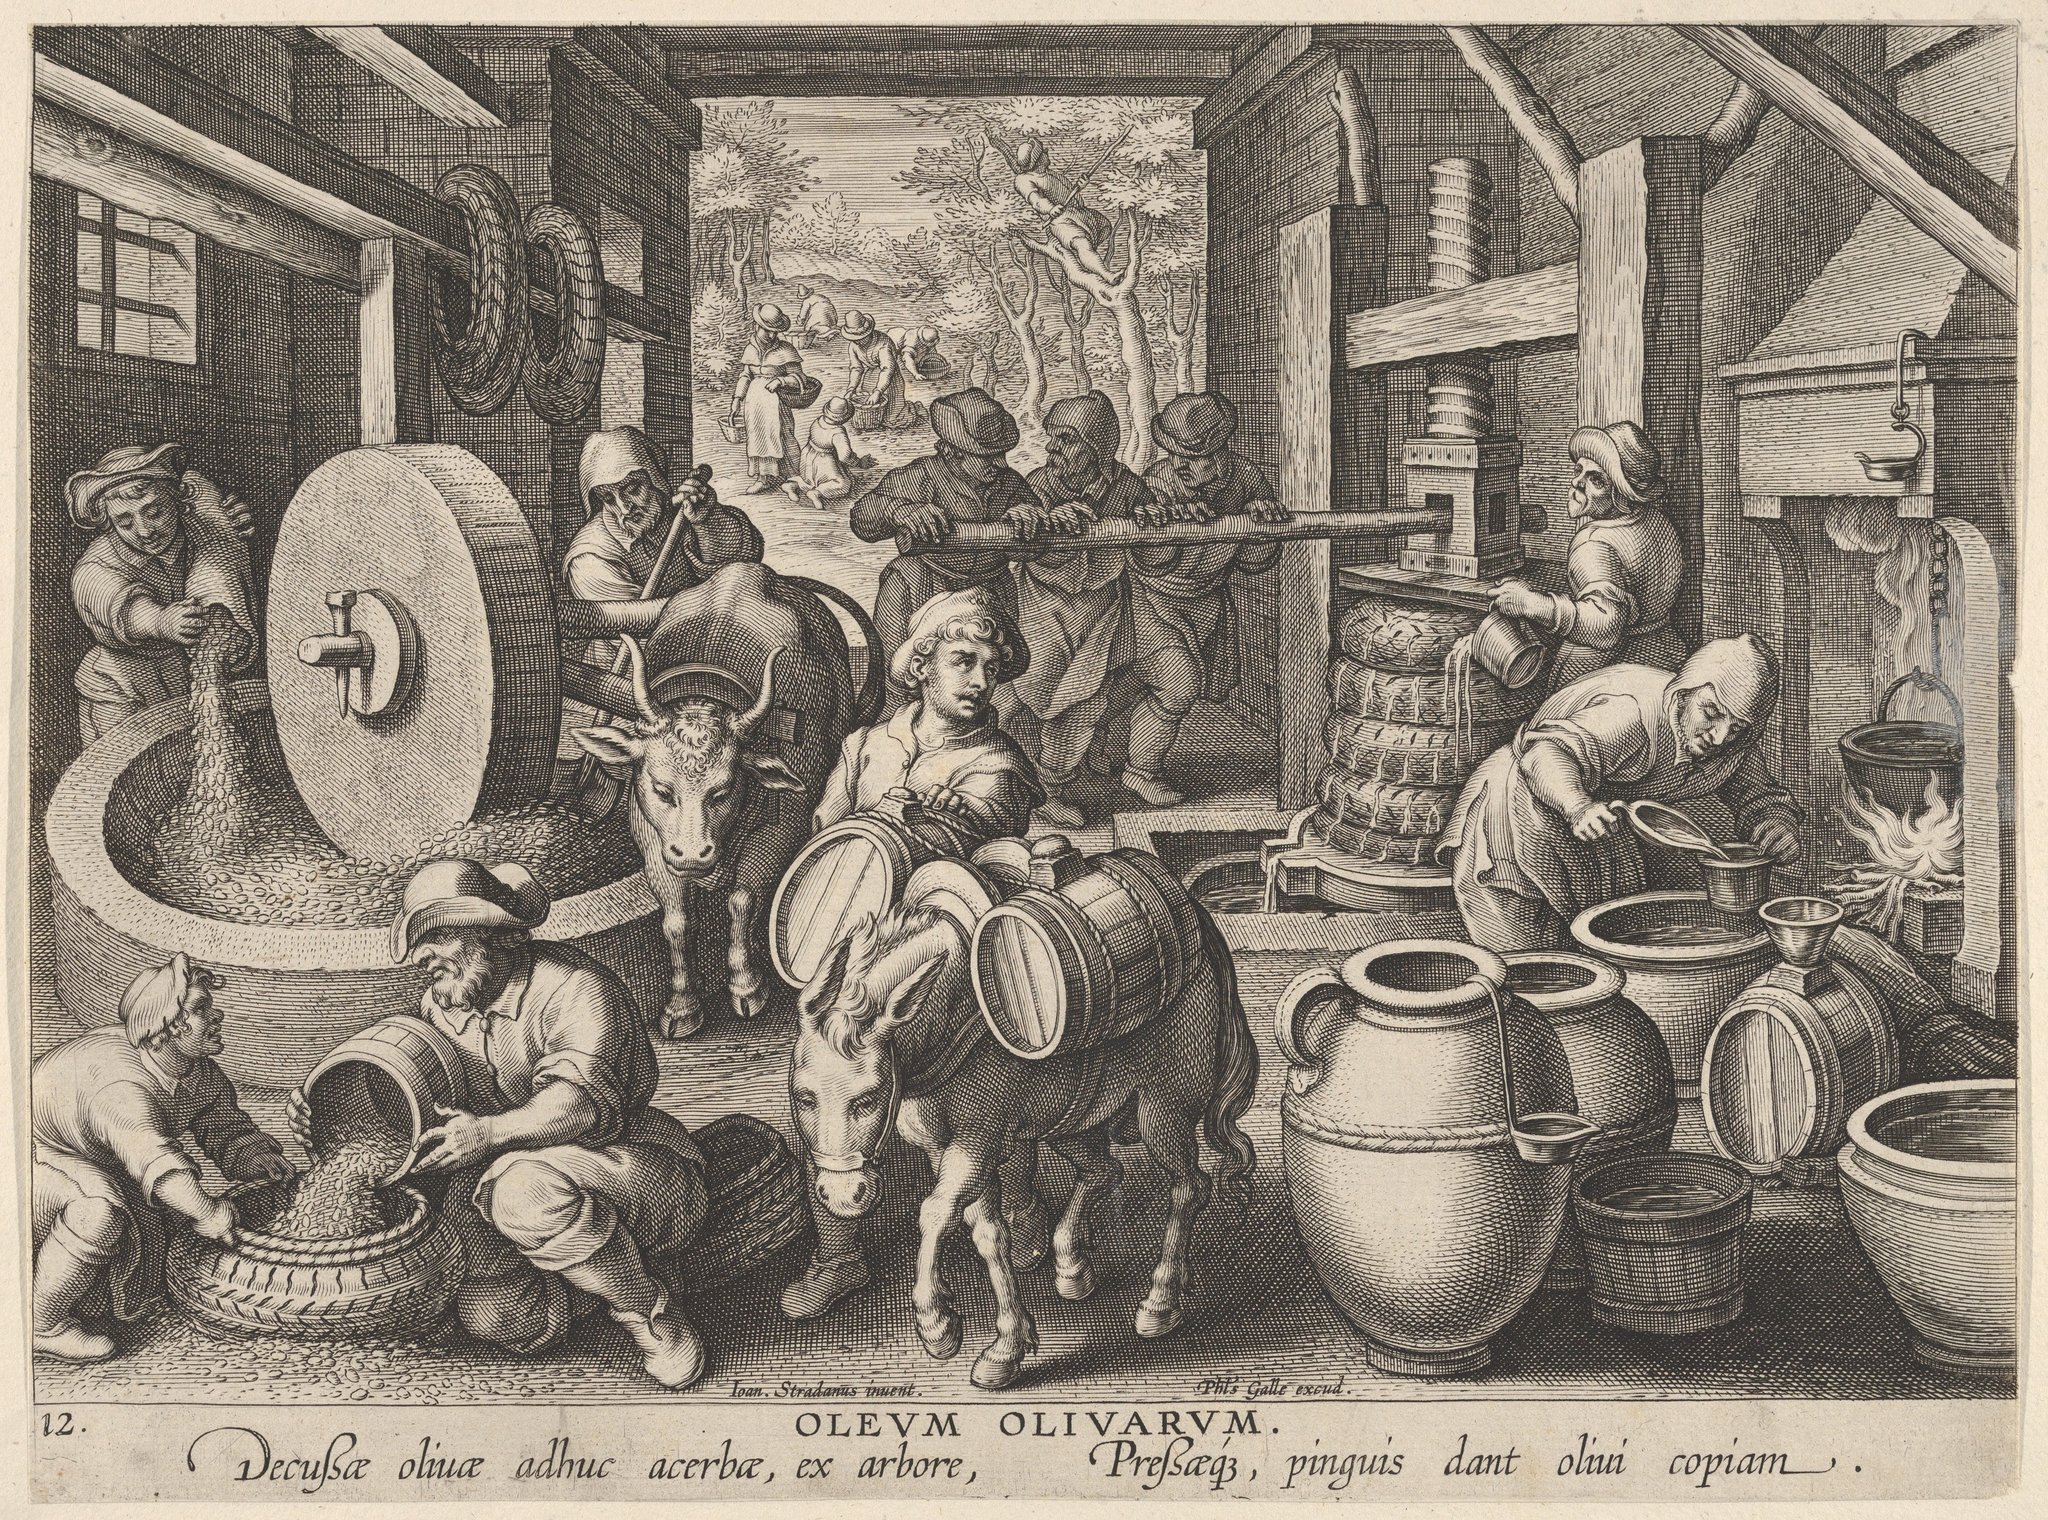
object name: print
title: New Inventions of Modern Times [Nova Reperta], The Invention of the Olive Oil Press, plate 12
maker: jan collaert i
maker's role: artist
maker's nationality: netherlandish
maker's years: 1530-1581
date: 1600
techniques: engraving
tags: men,women,cows,donkeys,working,industry